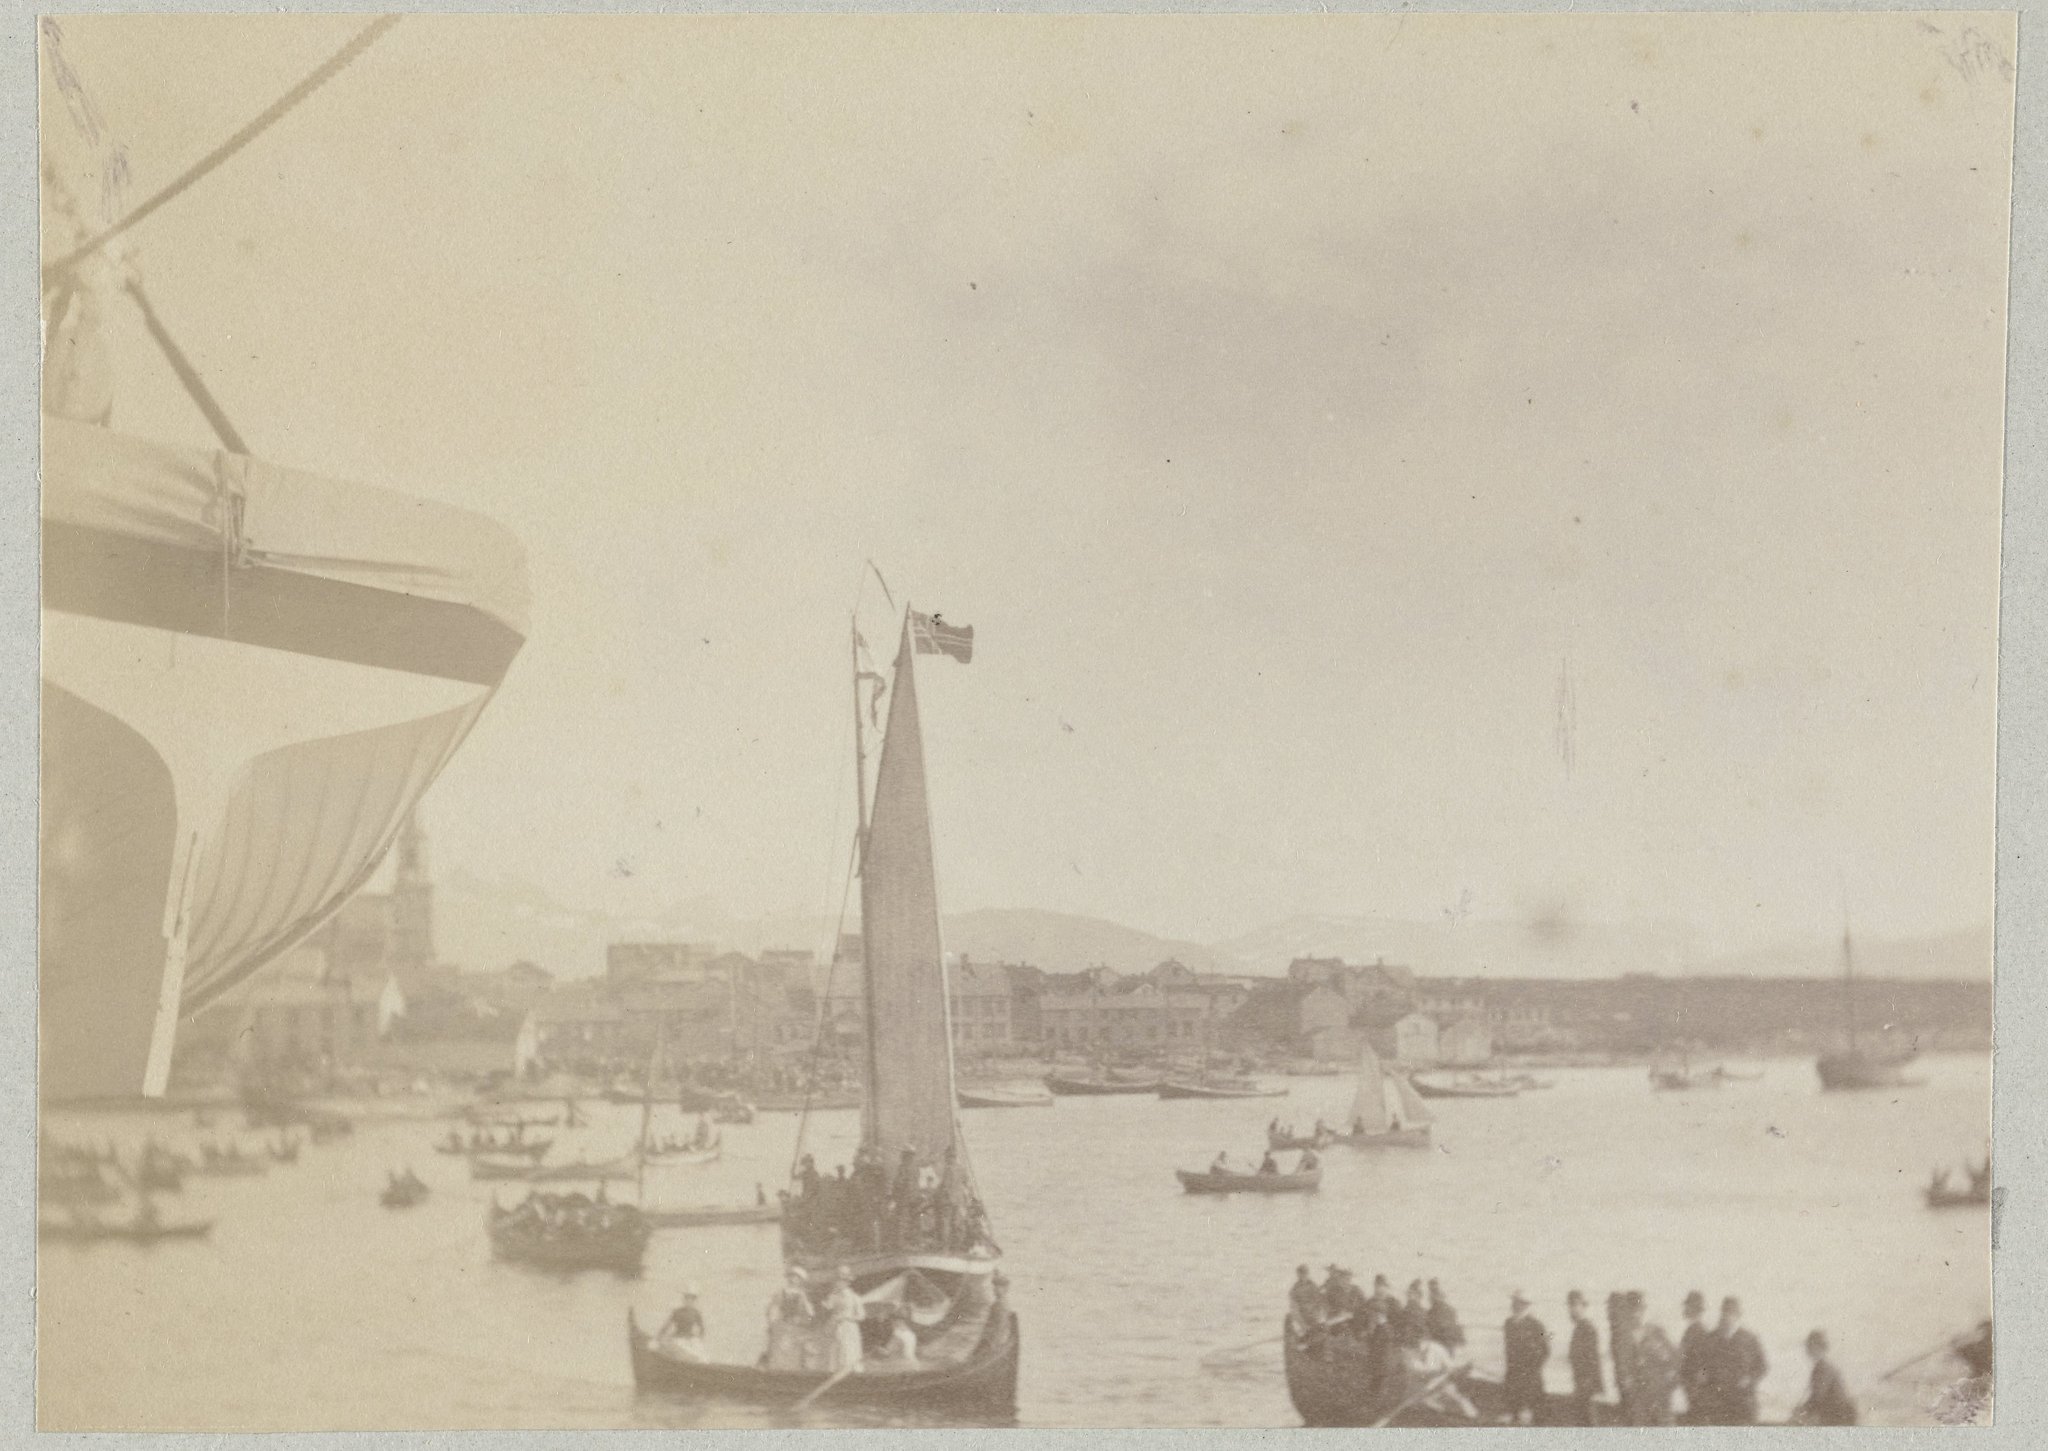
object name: photograph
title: Auf der fahrt nach Bodö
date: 1807-1889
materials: cardboard, paper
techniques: albumen print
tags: wilhelm ii (keizer van duitsland), norway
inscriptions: number: ‘23’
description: De afdruk van de foto is rond, het papier vierkant